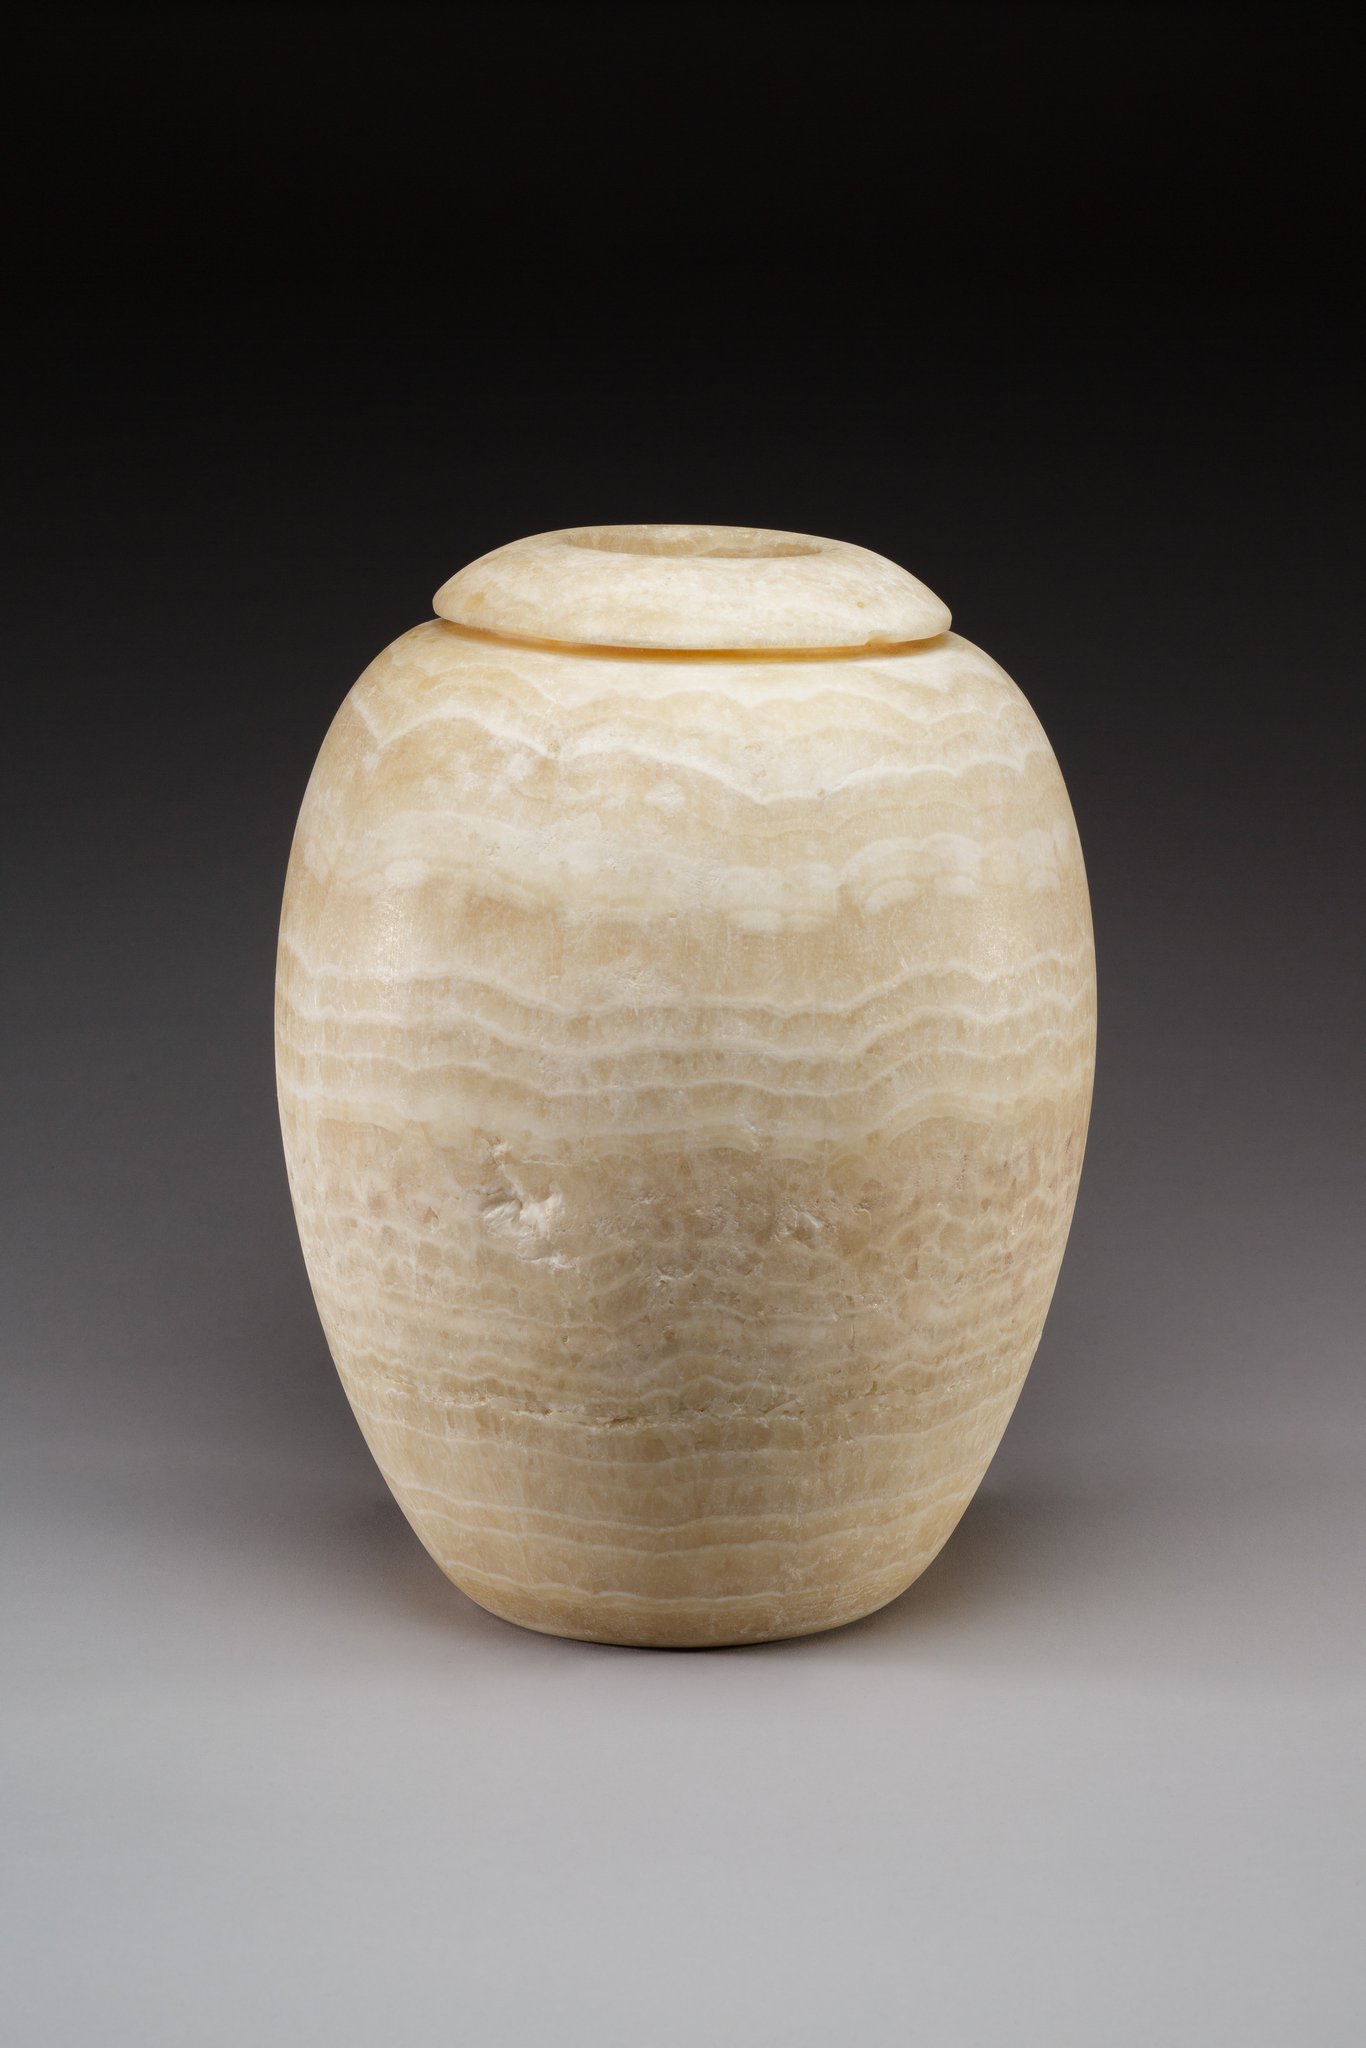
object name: jar, ovoid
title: Ovoid jar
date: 2750-2649 BCE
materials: stone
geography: egypt